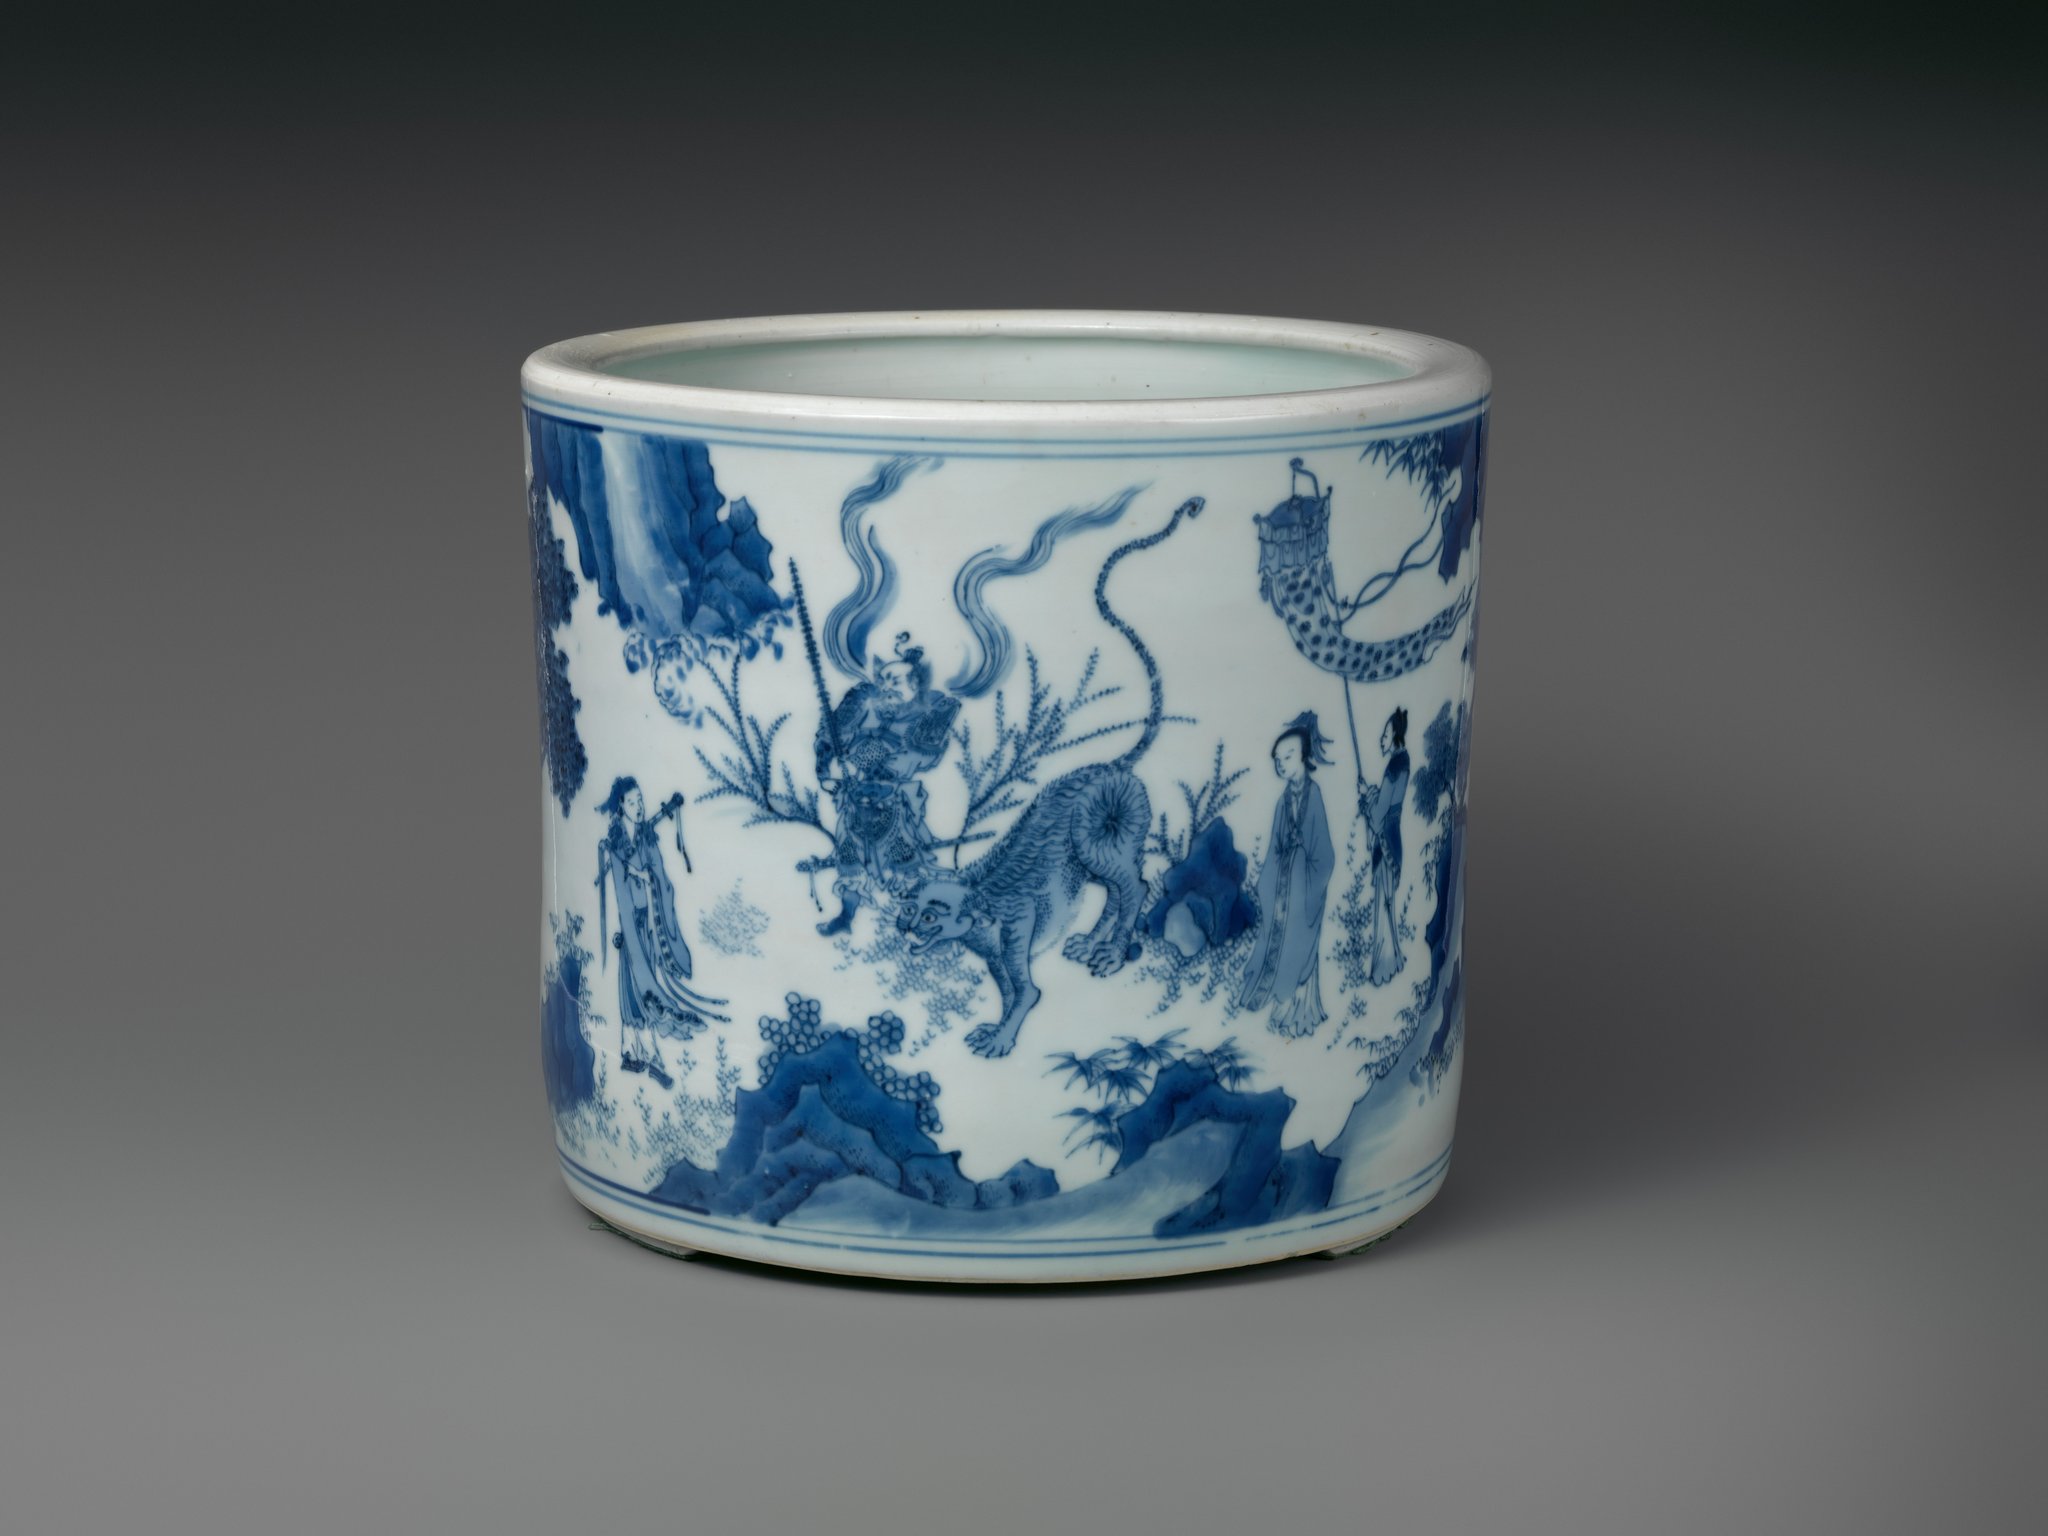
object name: brush pot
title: Brush holder with scene from Investiture of the Gods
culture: chinese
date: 1634-1666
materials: cobalt, glaze, porcelain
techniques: painting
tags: men,women,tigers